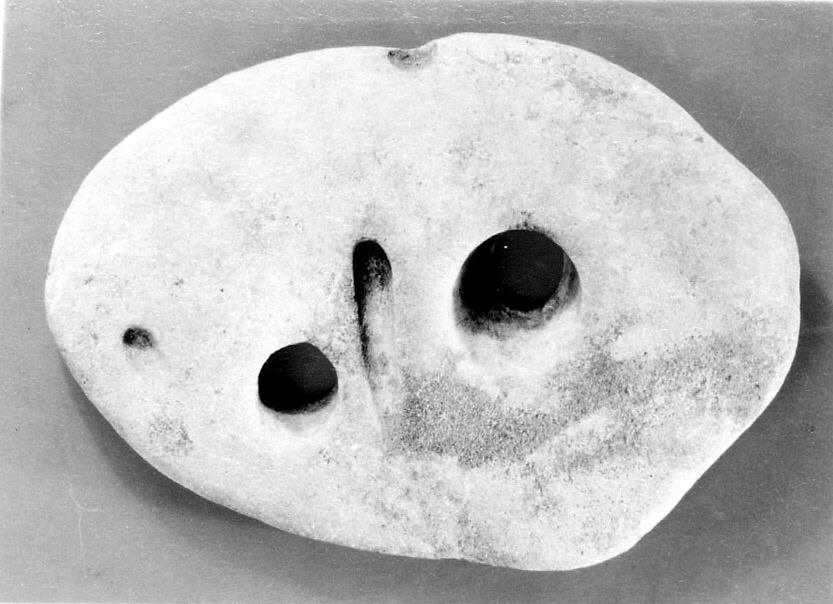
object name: mask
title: Stone Mask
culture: japanese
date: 1000-250 BCE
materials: stone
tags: masks